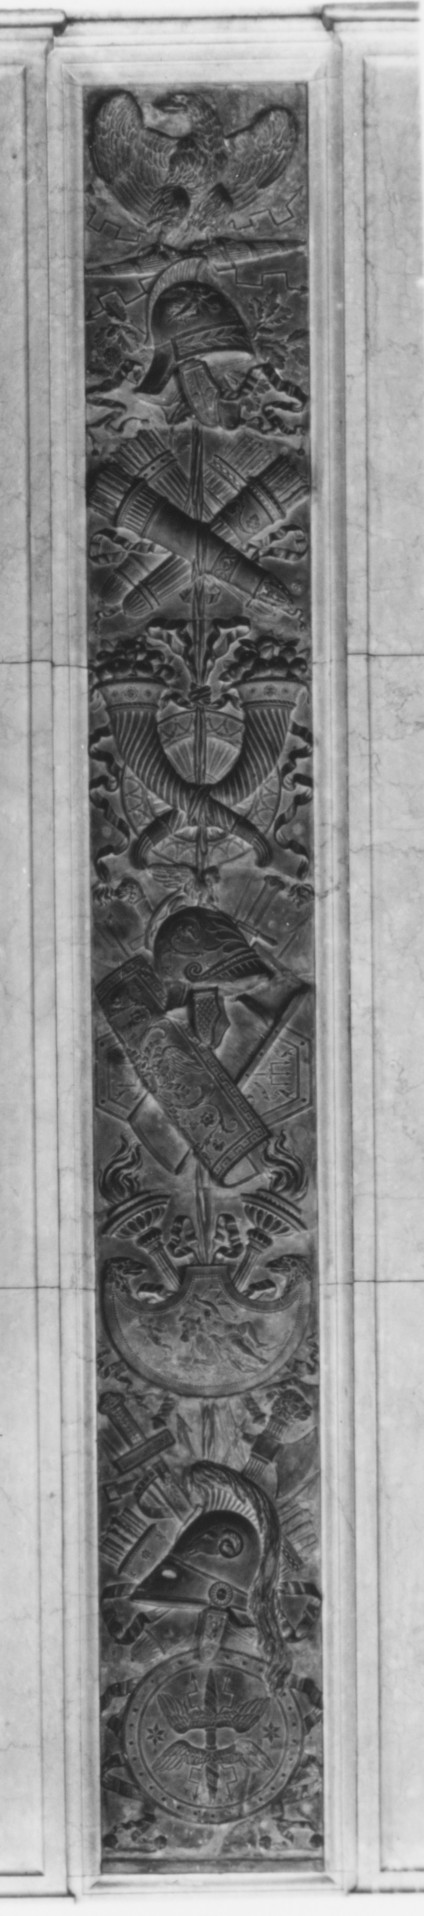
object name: pilaster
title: Pilaster (one of four)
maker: graziani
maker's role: artist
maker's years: 1762-1835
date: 1767-1833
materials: terracotta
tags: birds,helmets,swords